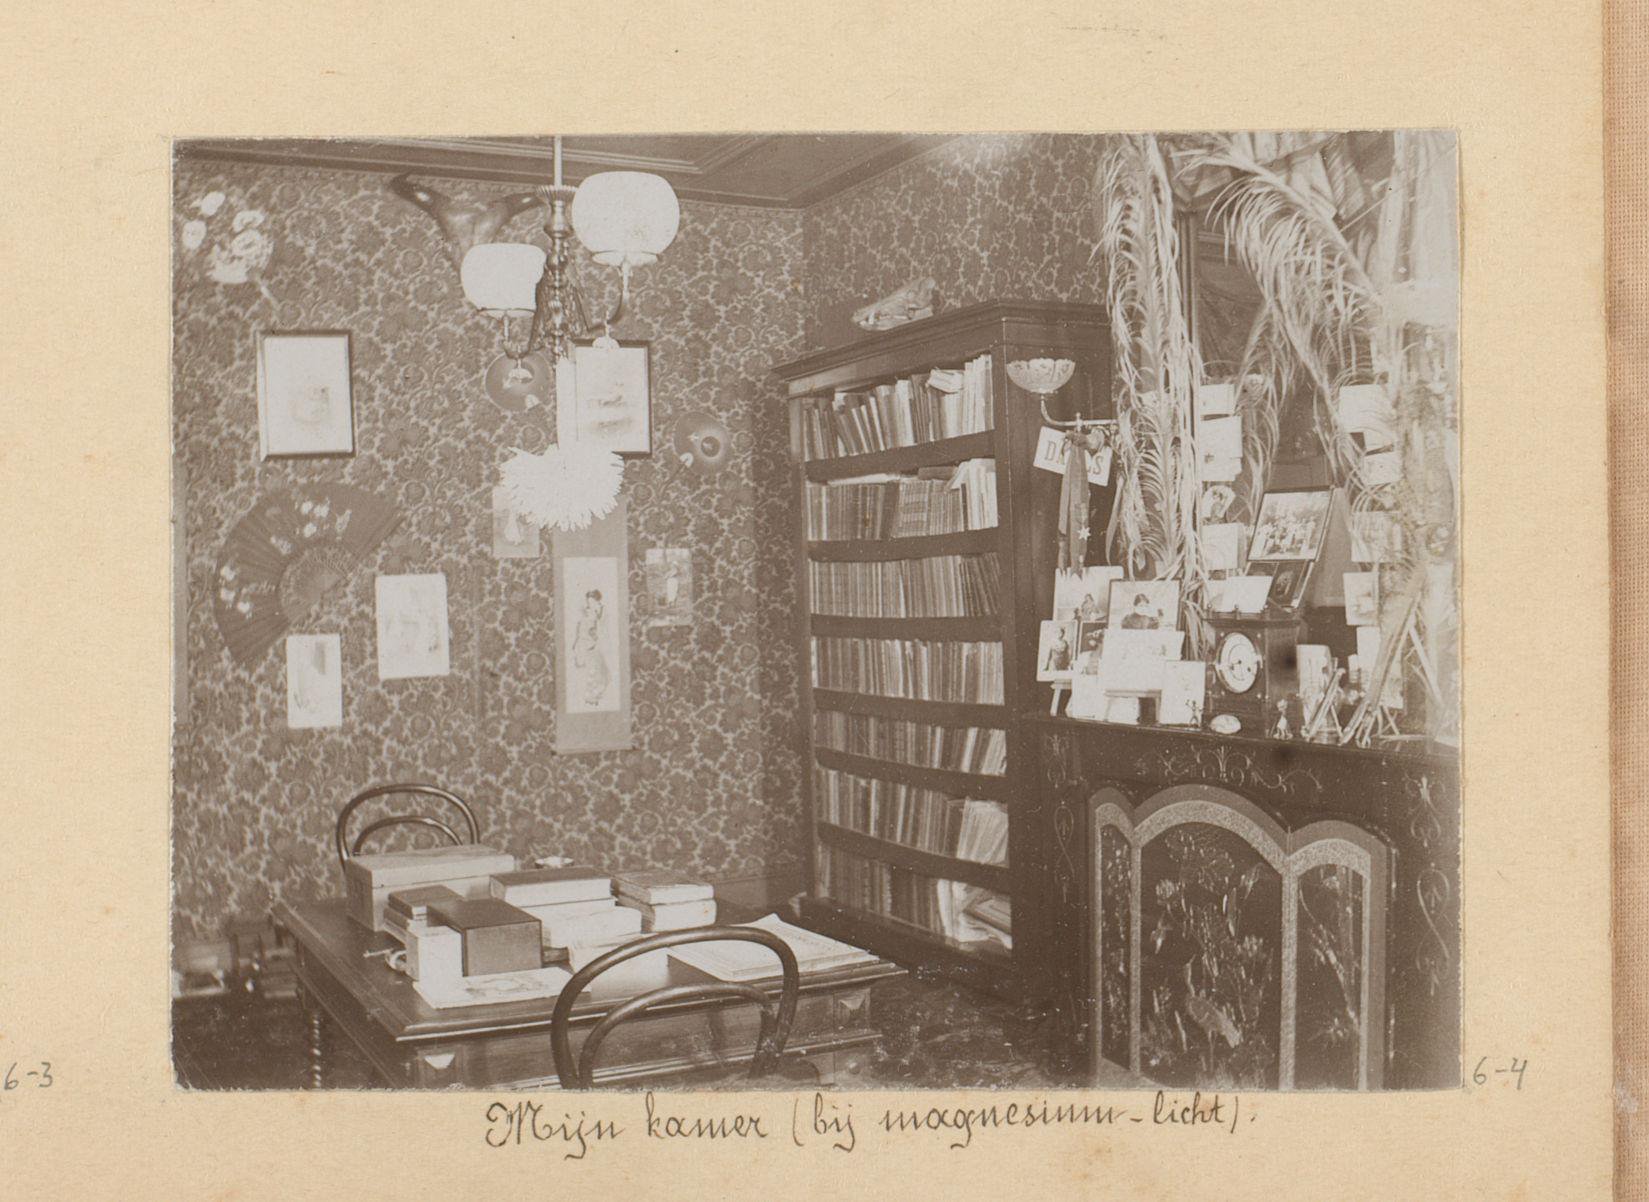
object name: photograph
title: Interieur van de kamer van Hendrik Herman van den Berg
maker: hendrik herman van den berg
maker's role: amateurfotograaf, jurist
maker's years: 1875-1944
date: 1890-1894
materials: paper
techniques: collodion silver print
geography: amsterdam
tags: interior ~ representation of a building, amsterdam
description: De foto is gemaakt bij flitslicht afkomstig van bliksempoeder.